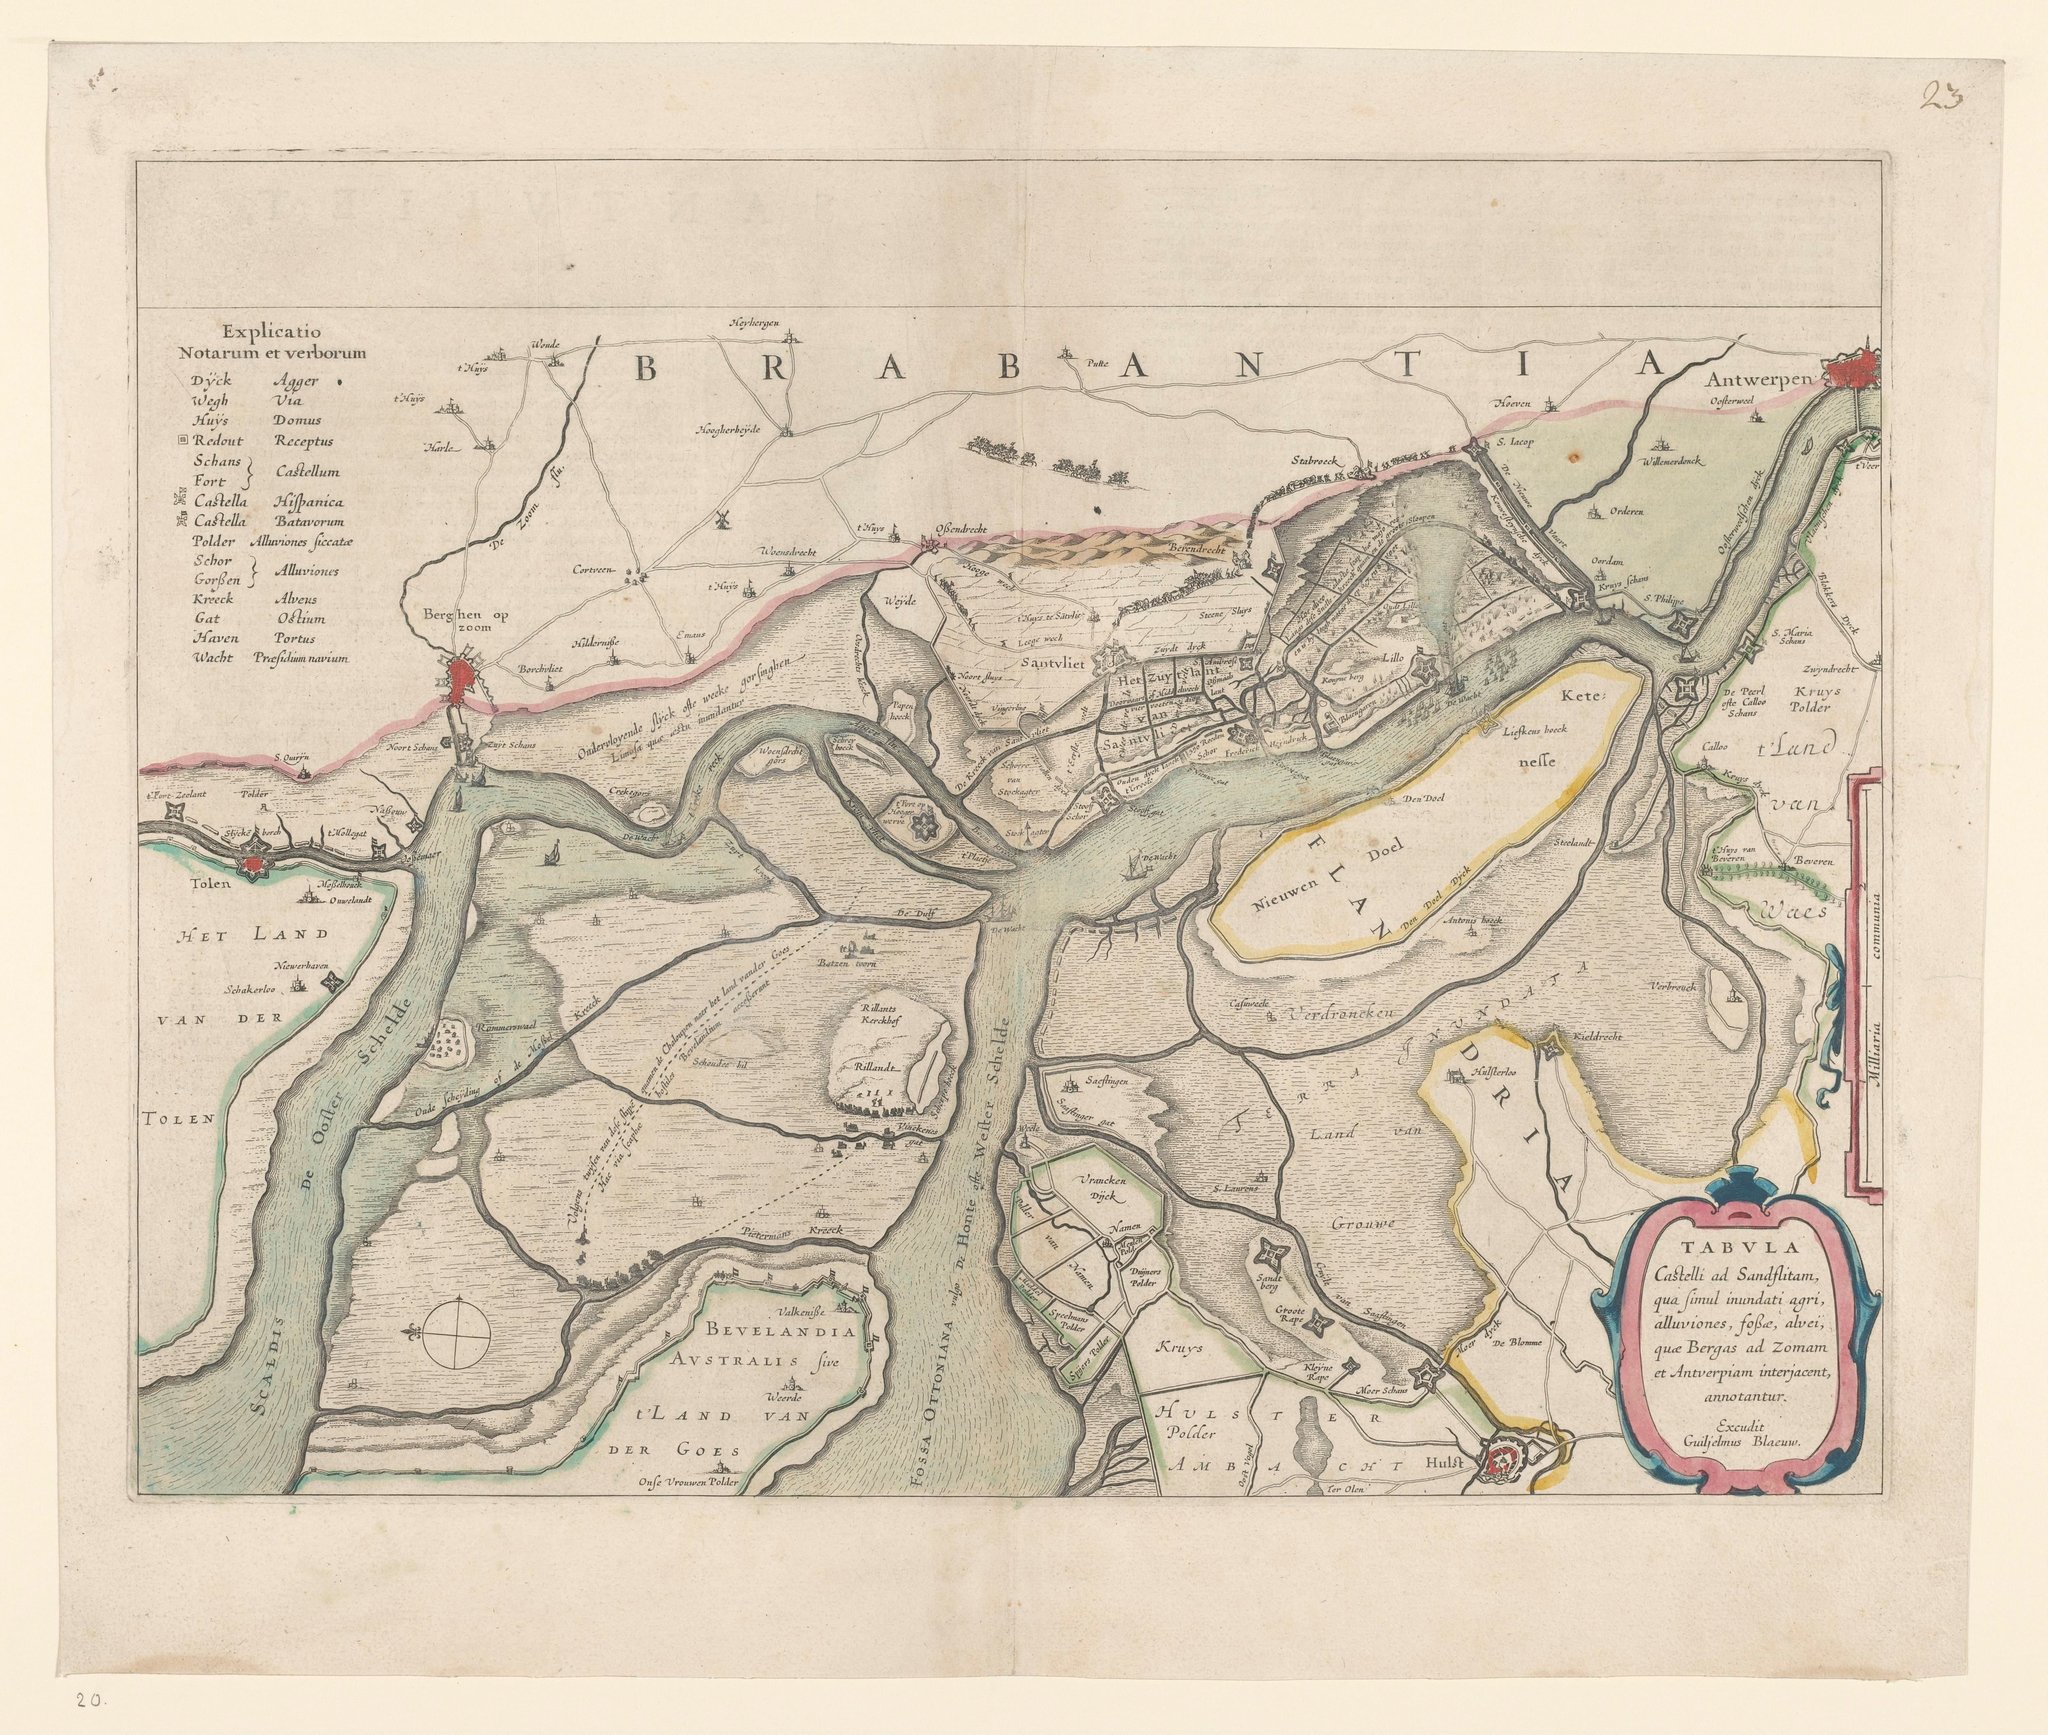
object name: map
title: Kaart van de omgeving van Zandvliet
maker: willem janszoon blaeu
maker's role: print maker, publisher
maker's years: 1571-1638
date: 1642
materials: paper, watercolor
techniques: engraving, hand coloring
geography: amsterdam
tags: maps of separate countries or regions, antwerp, bergen op zoom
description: Kaart van de omgeving van Zandvliet, het Noorden links, de grenzen gekleurd, steden, gebouwen en vlaggen aangegeven, de wegen soms bevolkt. Linksboven uitleg van de symbolen op de kaart, rechtsmidden schaal in landmijlen. Verso: twee pagina's tekst.